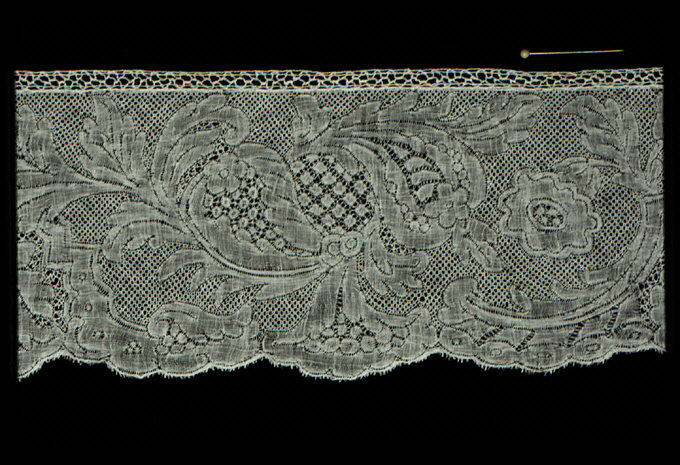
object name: edging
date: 1700-1750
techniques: lace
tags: flowers